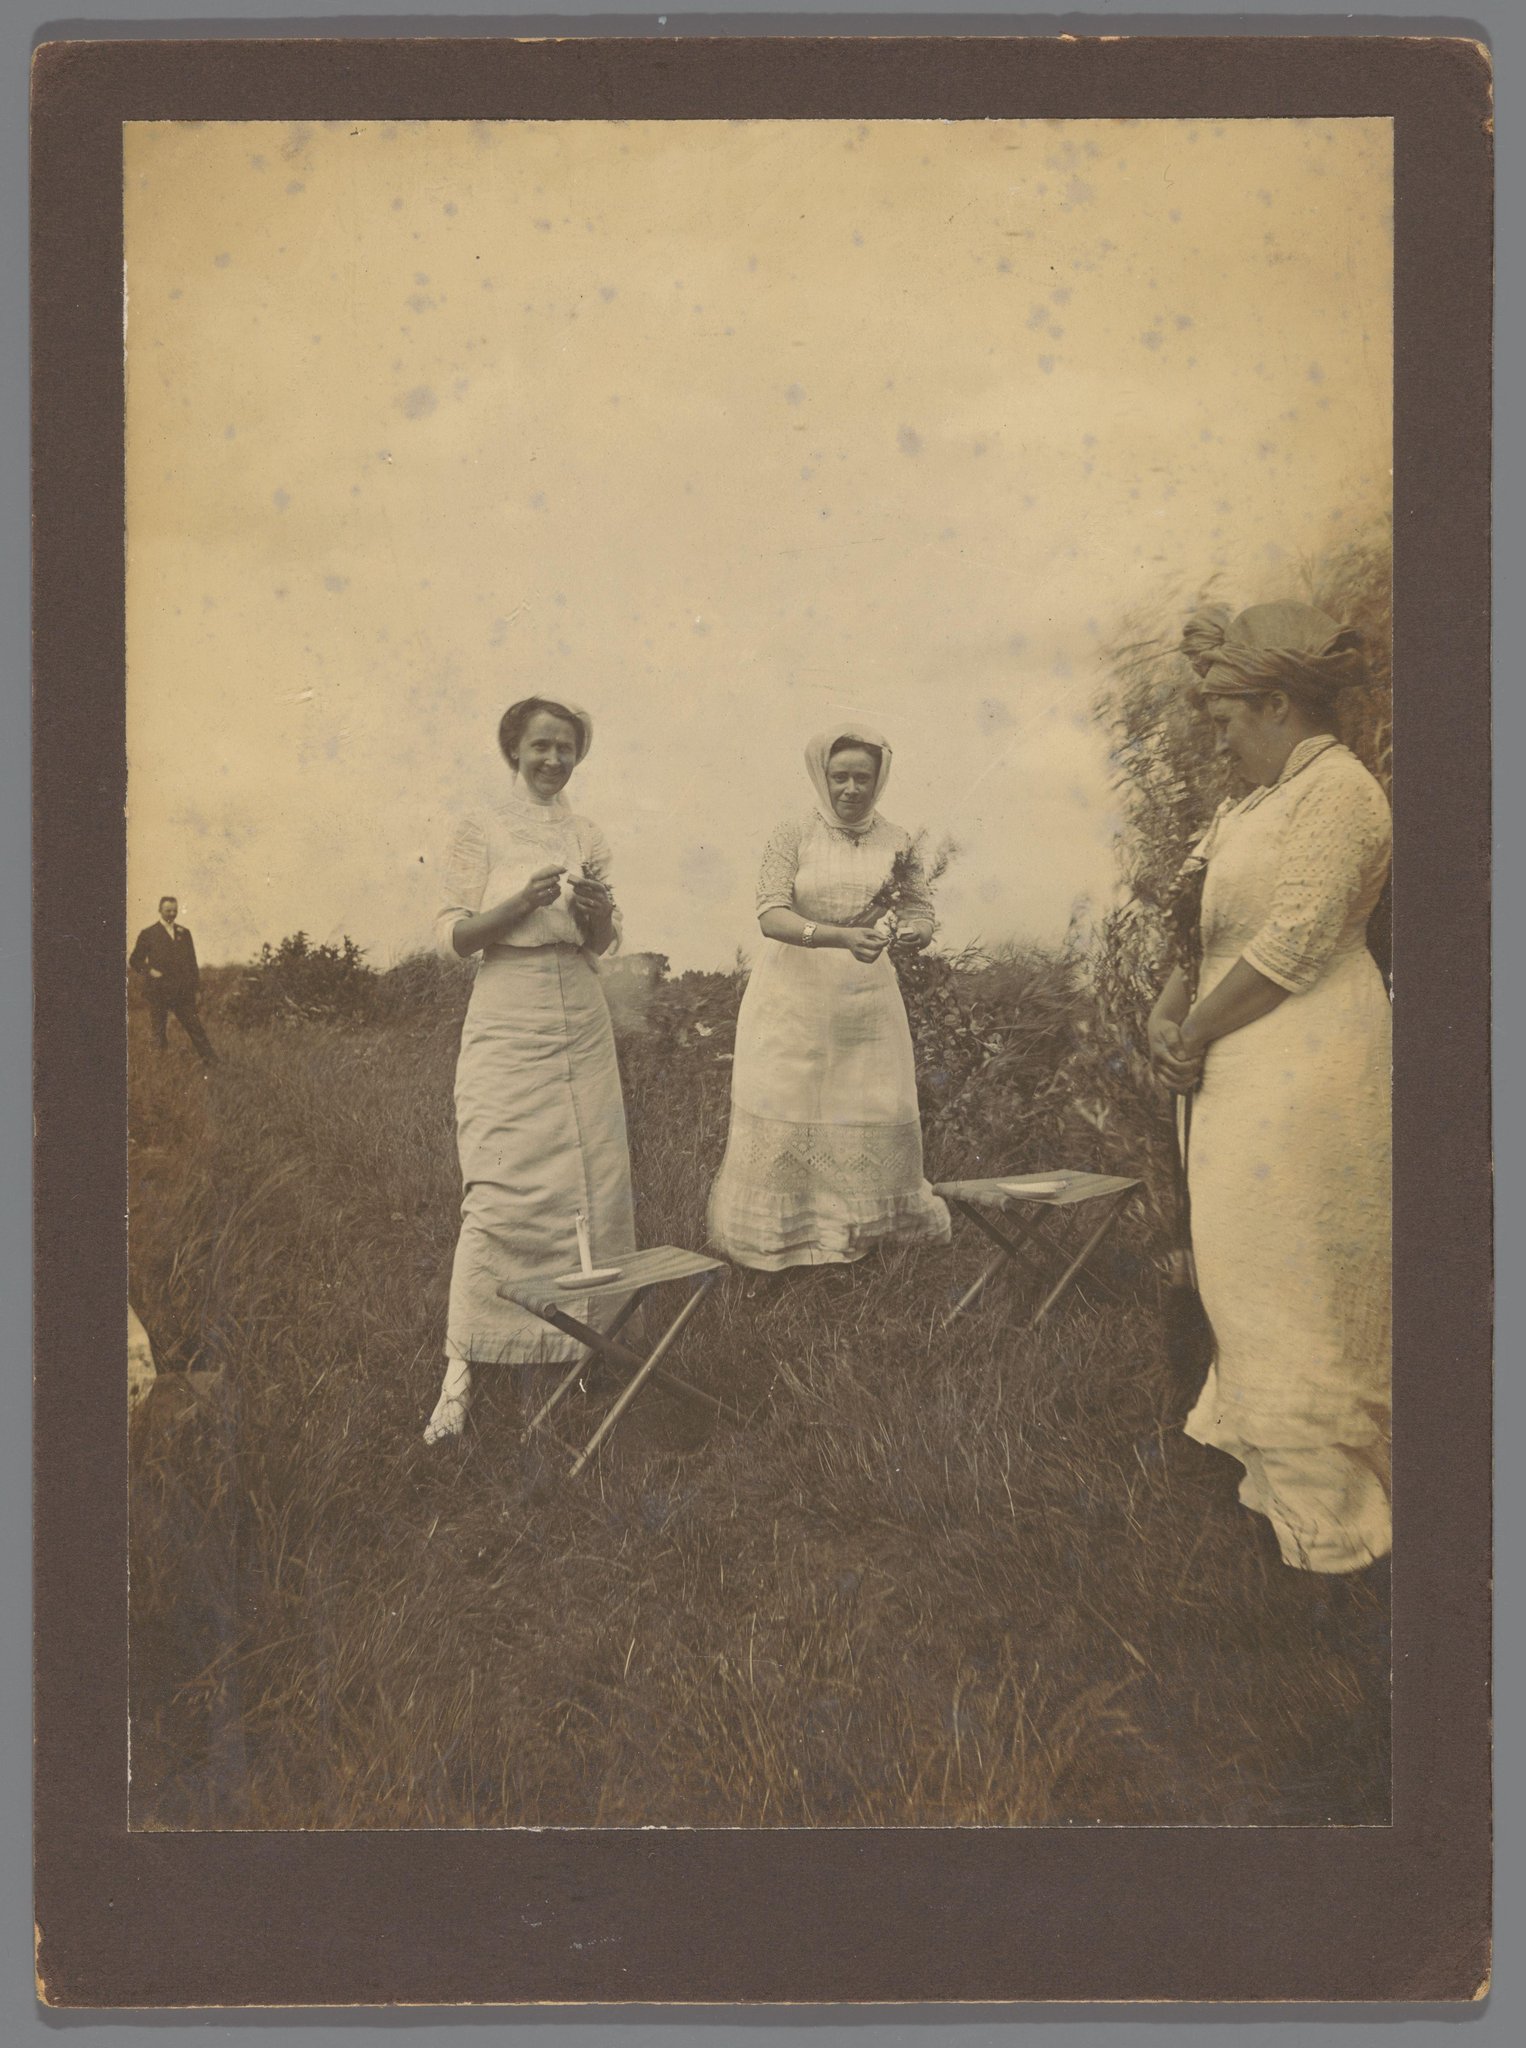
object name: photograph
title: Drie vrouwen branden een kaars in de buitenlucht, in de verte staat een man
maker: Anonymous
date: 1900-1920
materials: paper, cardboard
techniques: gelatin silver print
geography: netherlands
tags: adult woman, candle